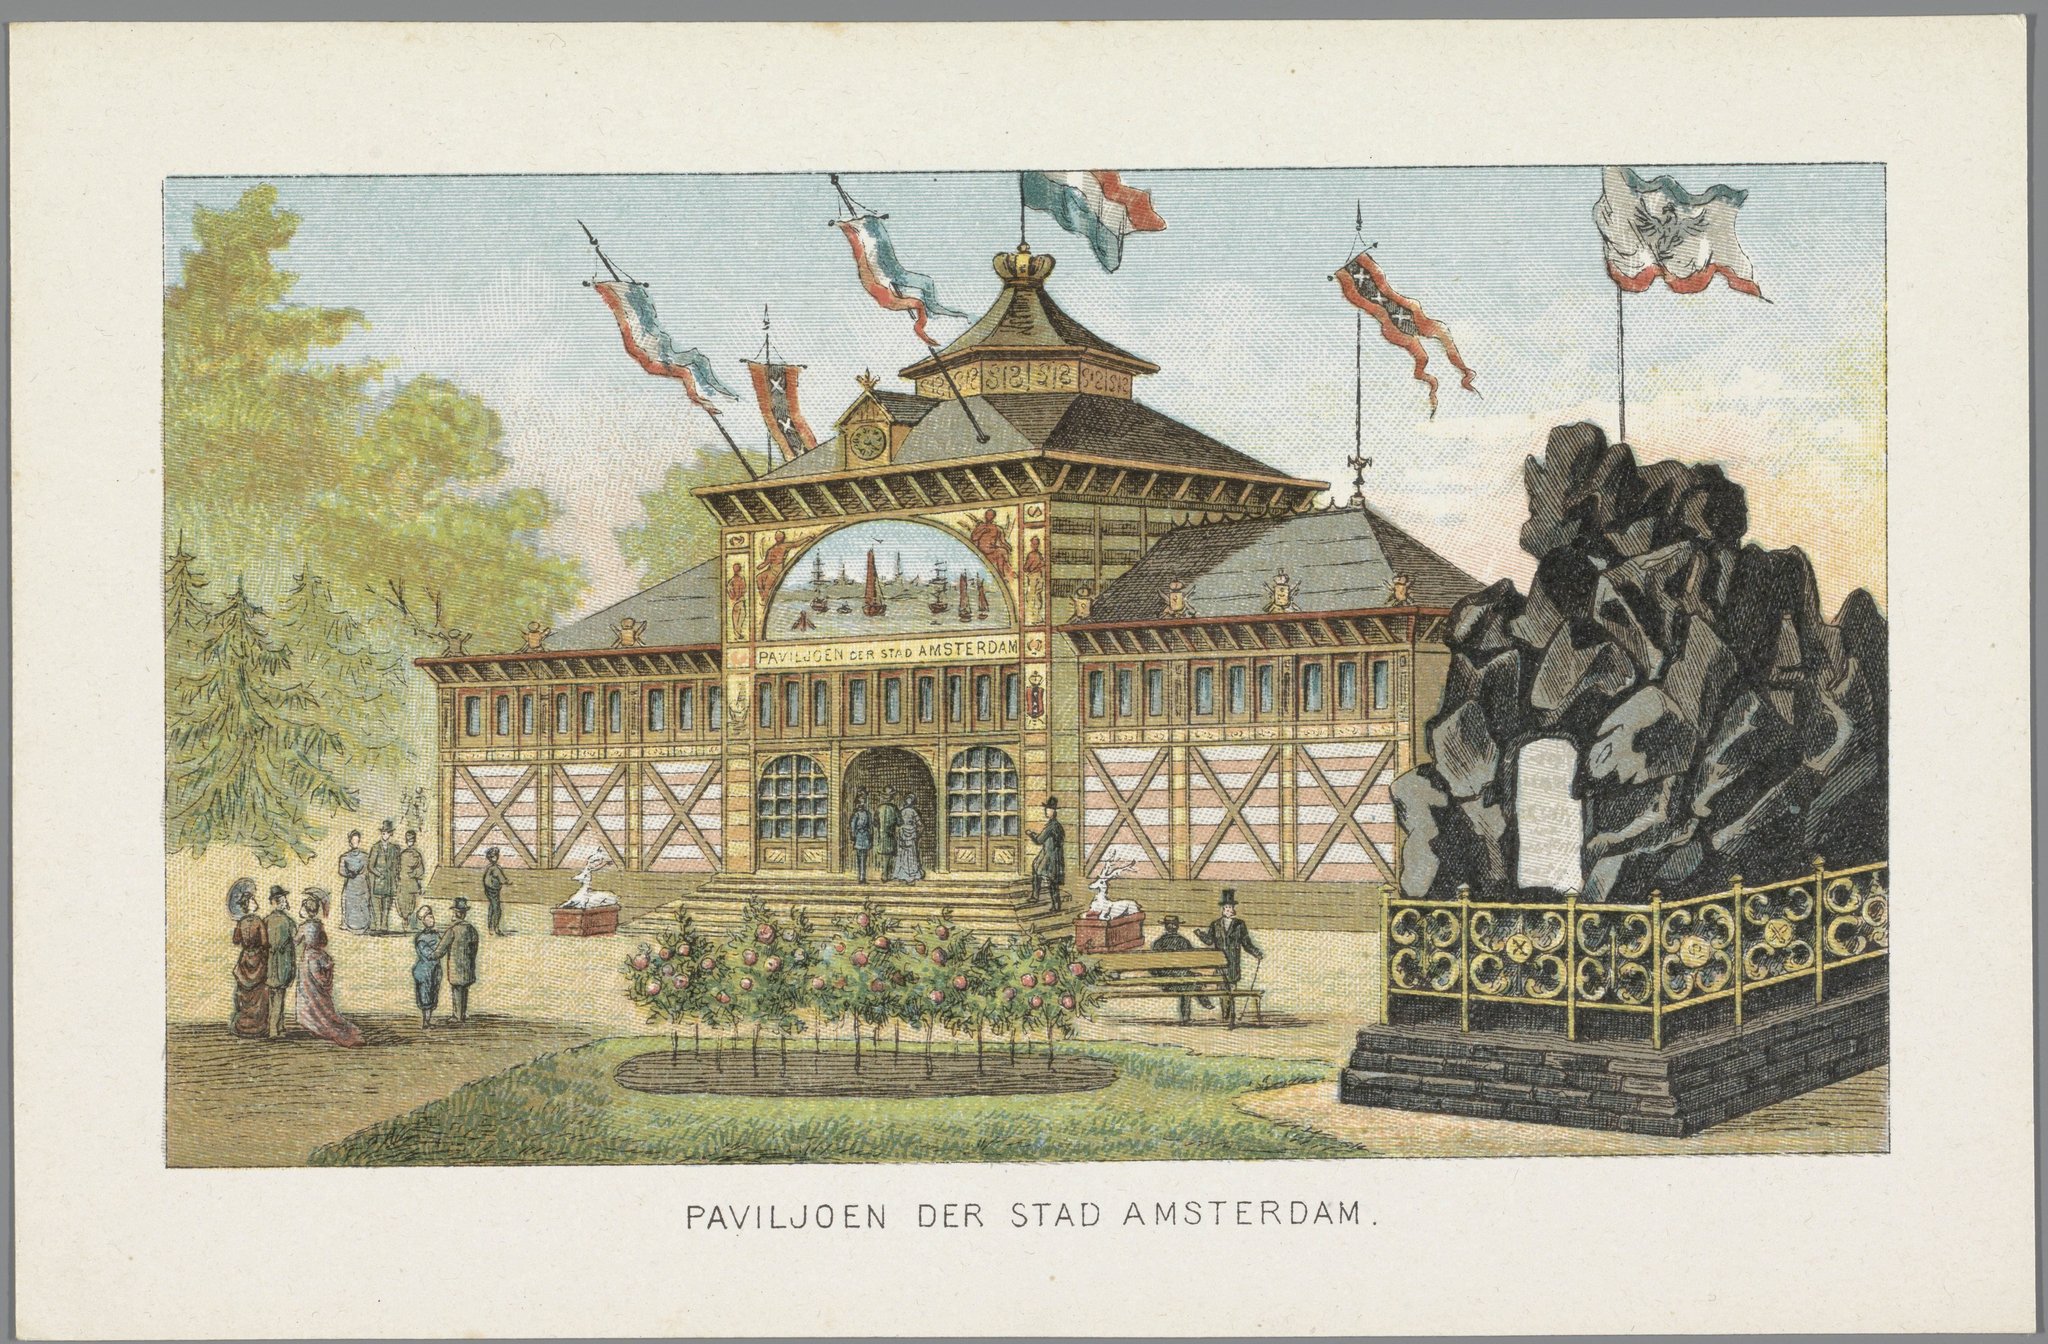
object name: print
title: Paviljoen der stad Amsterdam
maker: Anonymous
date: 1883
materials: paper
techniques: chromolithography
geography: netherlands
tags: world fair, world exhibition, amsterdam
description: Paviljoen van de stad Amsterdam op de Wereldtentoonstelling op het Museumplein te Amsterdam. Onderdeel van een groep van zestien platen en een plattegrond van de Wereldtentoonstelling in Amsterdam van 1 mei tot 1 oktober 1883. Uitgave van het Nieuws van den Dag.